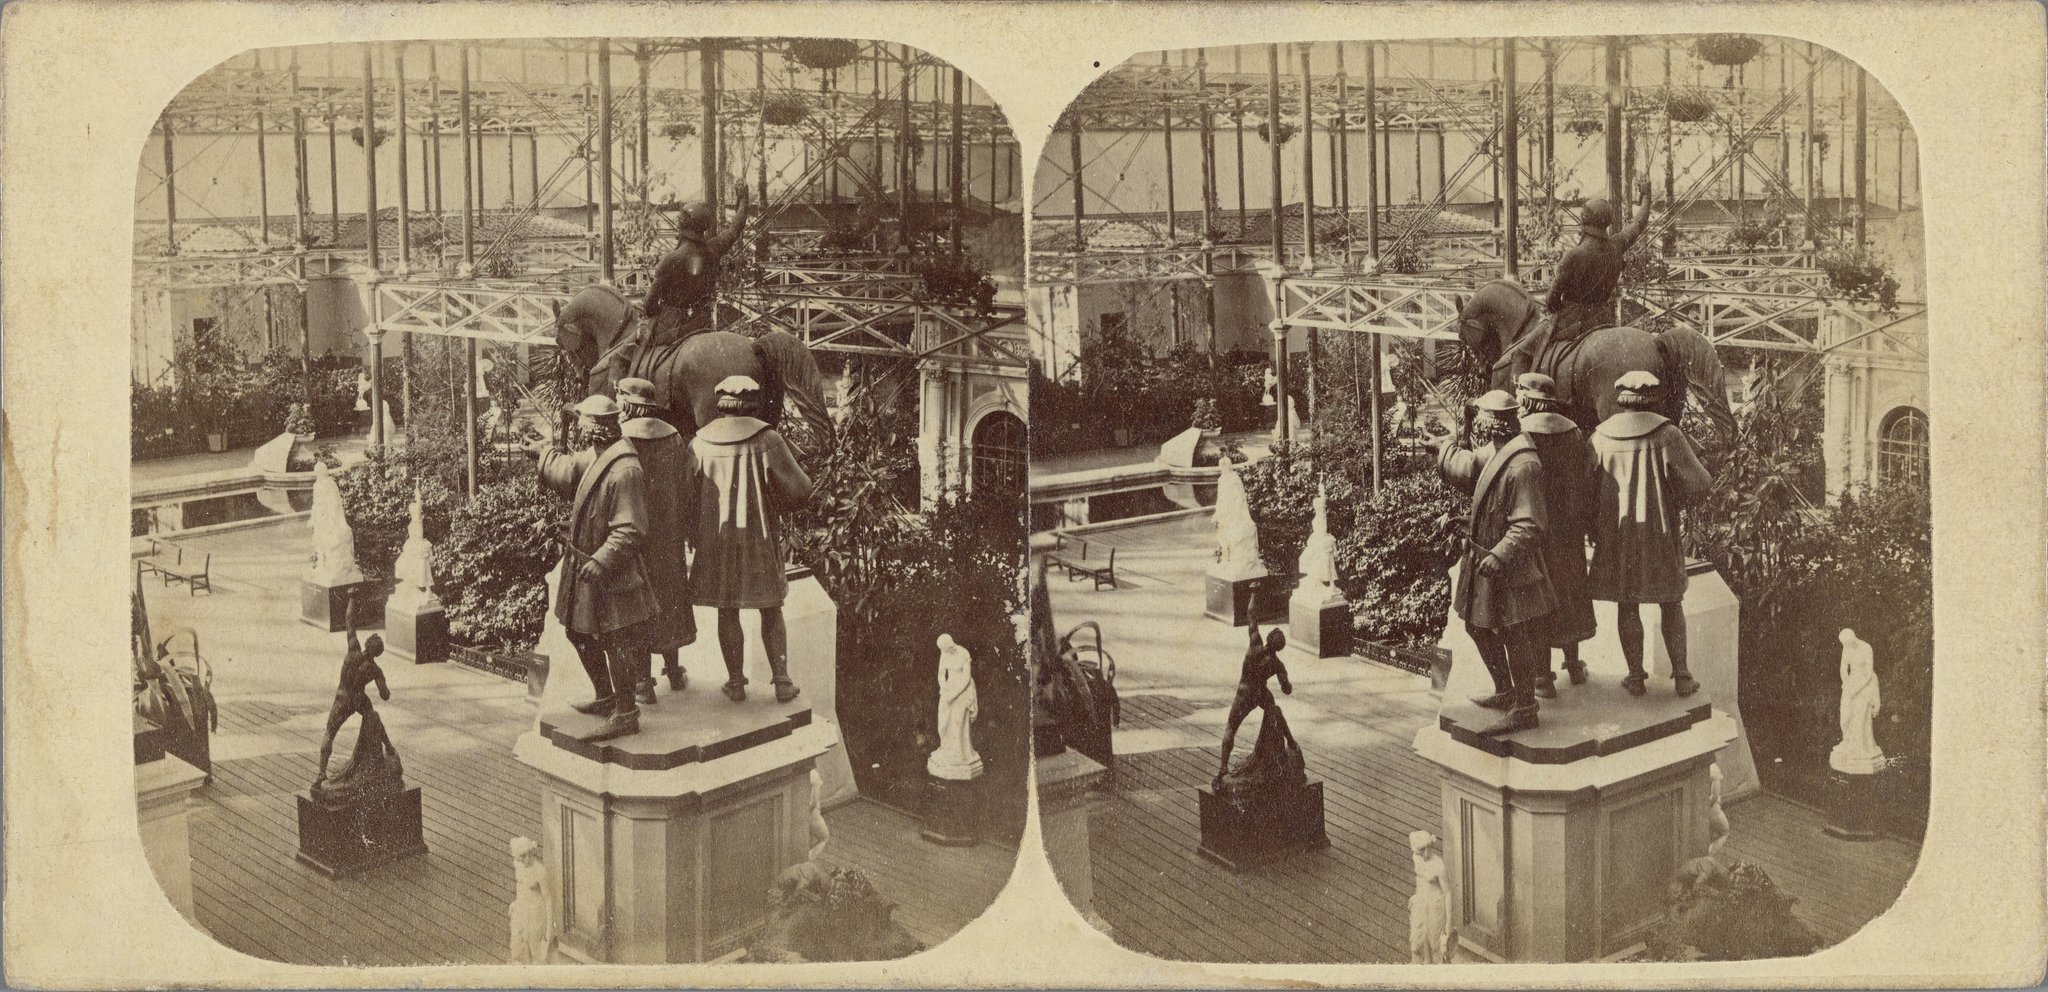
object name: stereograph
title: Crystal Palace. 64. General view in the south transept, from the Gallery.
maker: Anonymous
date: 1870-1890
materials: cardboard, paper, photographic support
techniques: albumen print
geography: crystal palace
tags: gallery of sculptures